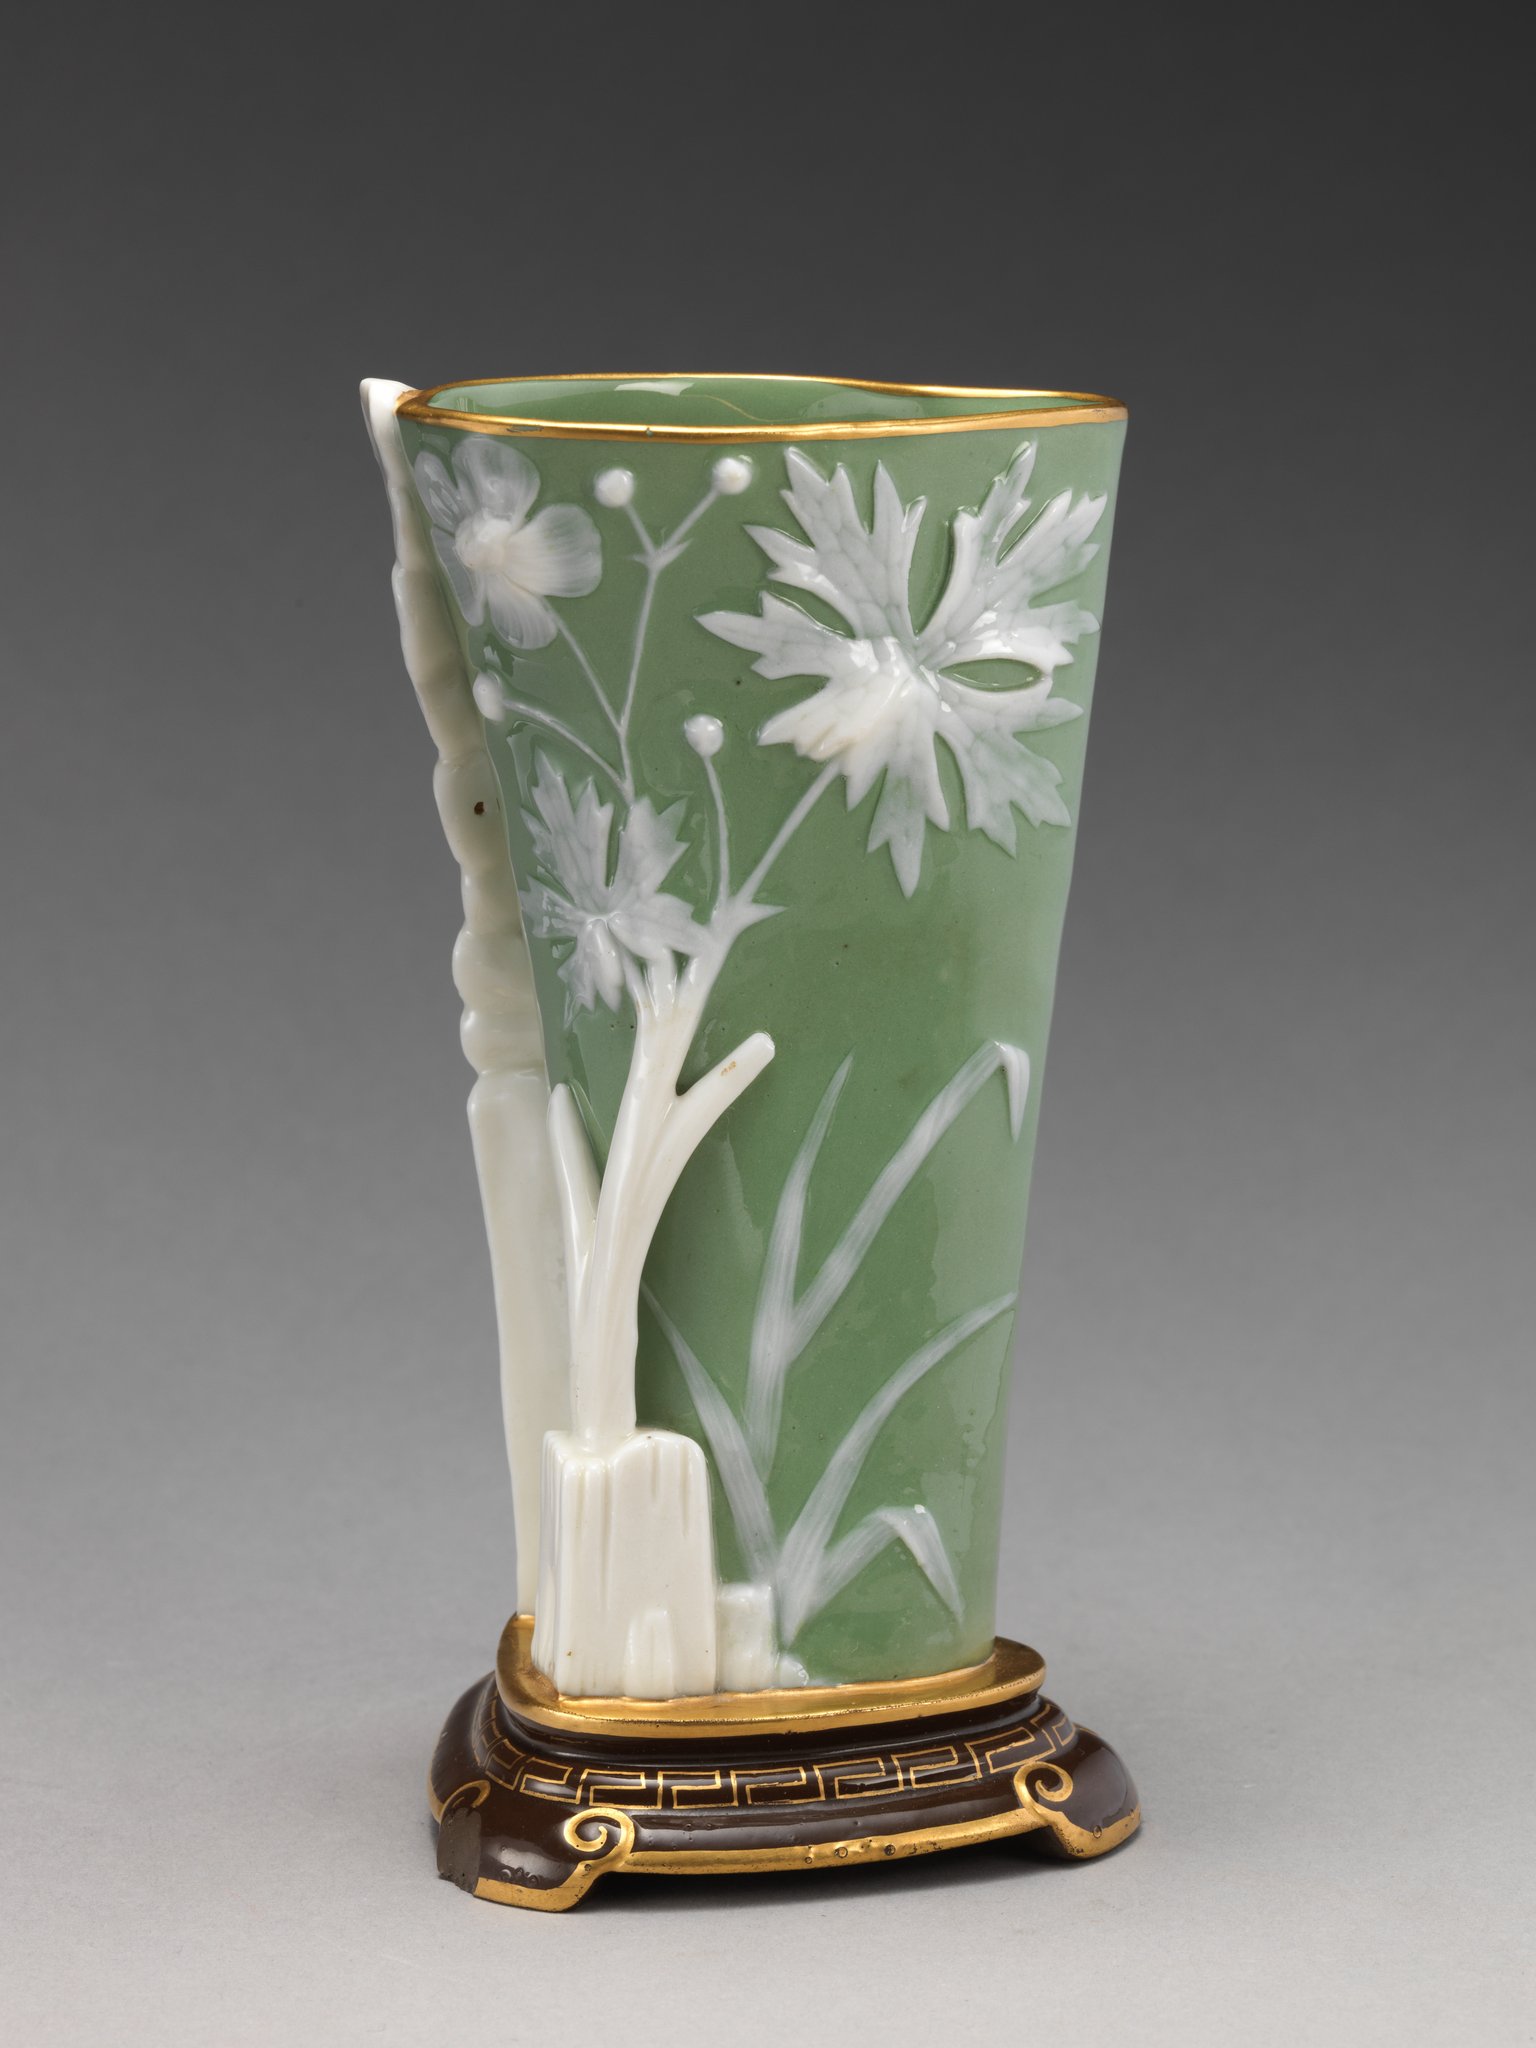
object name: vase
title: Triangular shaped vase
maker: minton(s)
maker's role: maker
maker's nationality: british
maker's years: 1793-2001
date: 1870-1879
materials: porcelain